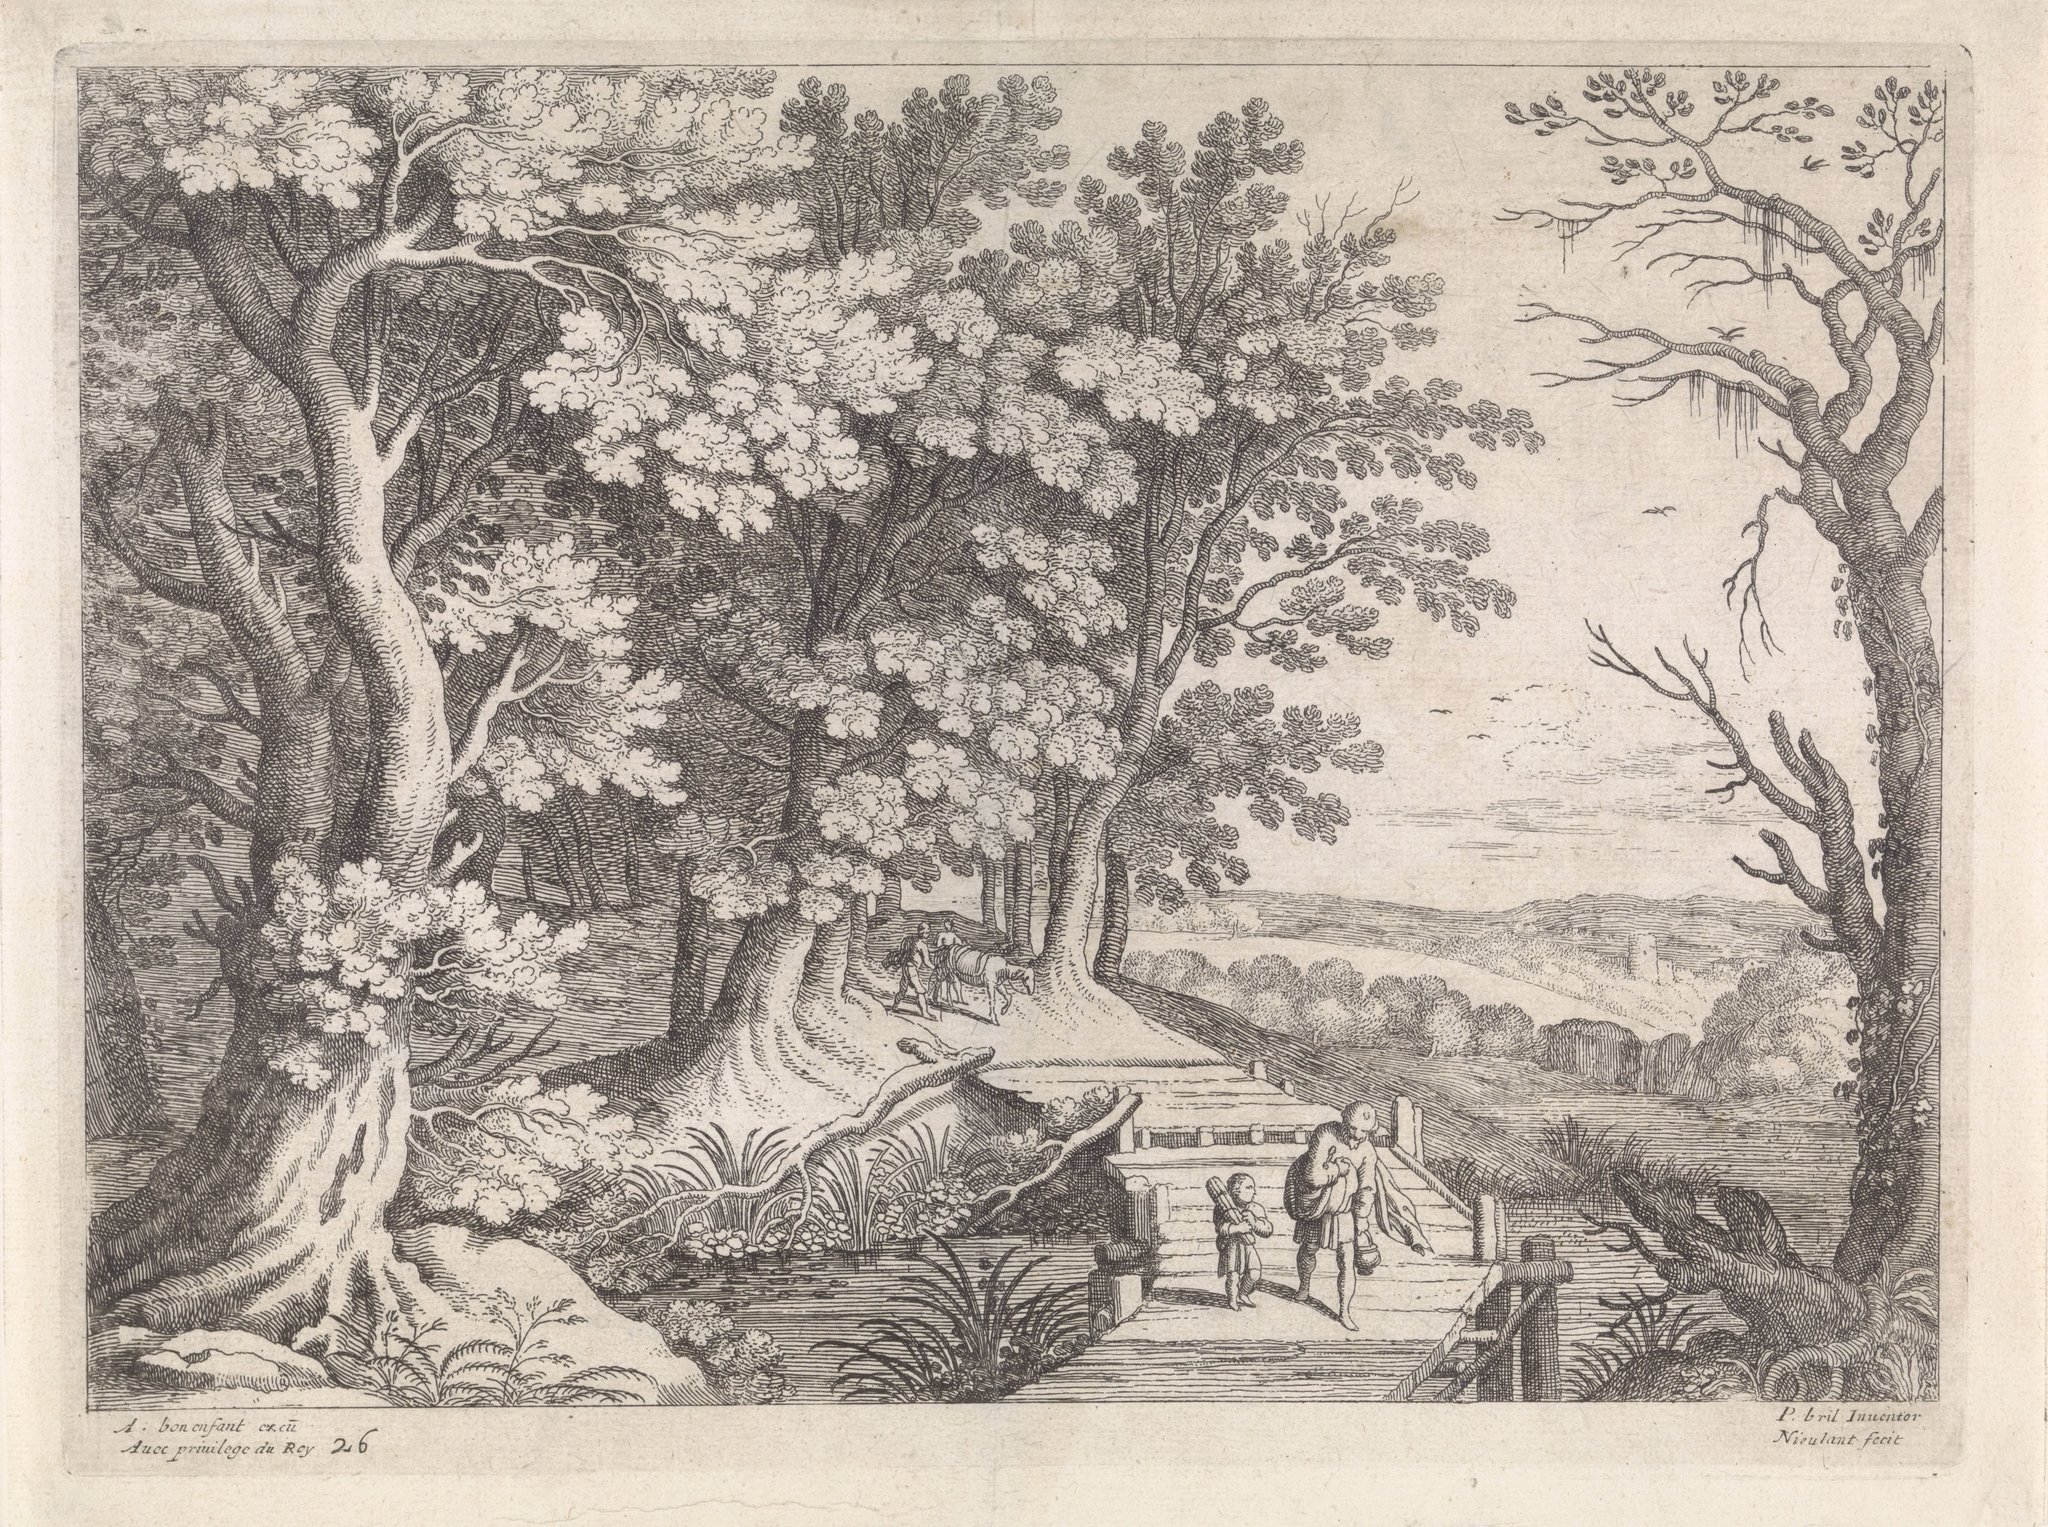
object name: print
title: Landschap met Abraham en Isaak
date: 1594-1635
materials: paper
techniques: etching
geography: paris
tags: landscapes in the temperate zone, the servants are left behind while abraham and isaac (usually carrying wood) climb the mountain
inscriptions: collector's mark: Lugt 2228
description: Abraham en zijn zoon Isaak, die het hout draagt, lopen over een houten brug in een bebost en heuvelachtig landschap naar de offerplaats. De twee knechten en de ezel hebben zij achter zich gelaten. Prent uit een serie Italiaanse landschappen.